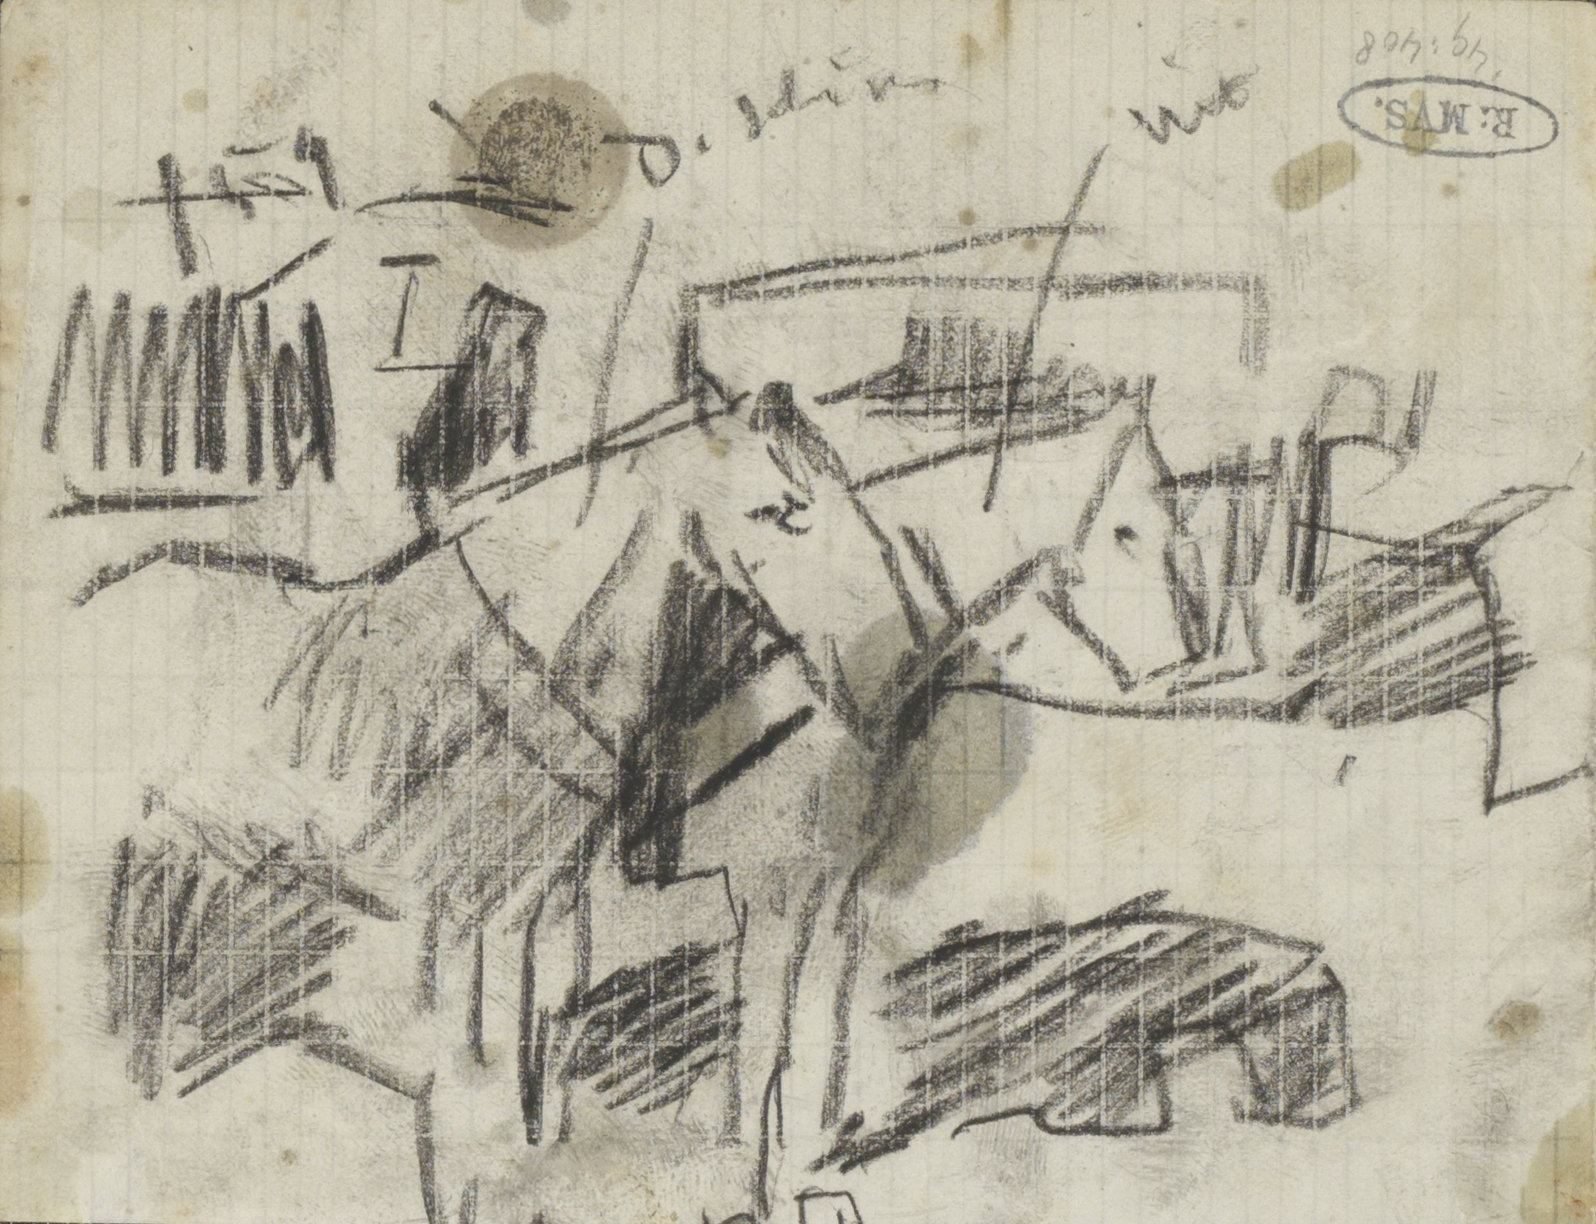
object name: drawing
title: Twee paarden, mogelijk op een bouwterrein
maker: george hendrik breitner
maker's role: draughtsman, painter, print maker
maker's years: 1857-1923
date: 1897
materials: chalk, paper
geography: amsterdam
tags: horse, building-site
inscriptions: collector's mark: Lugt 2228